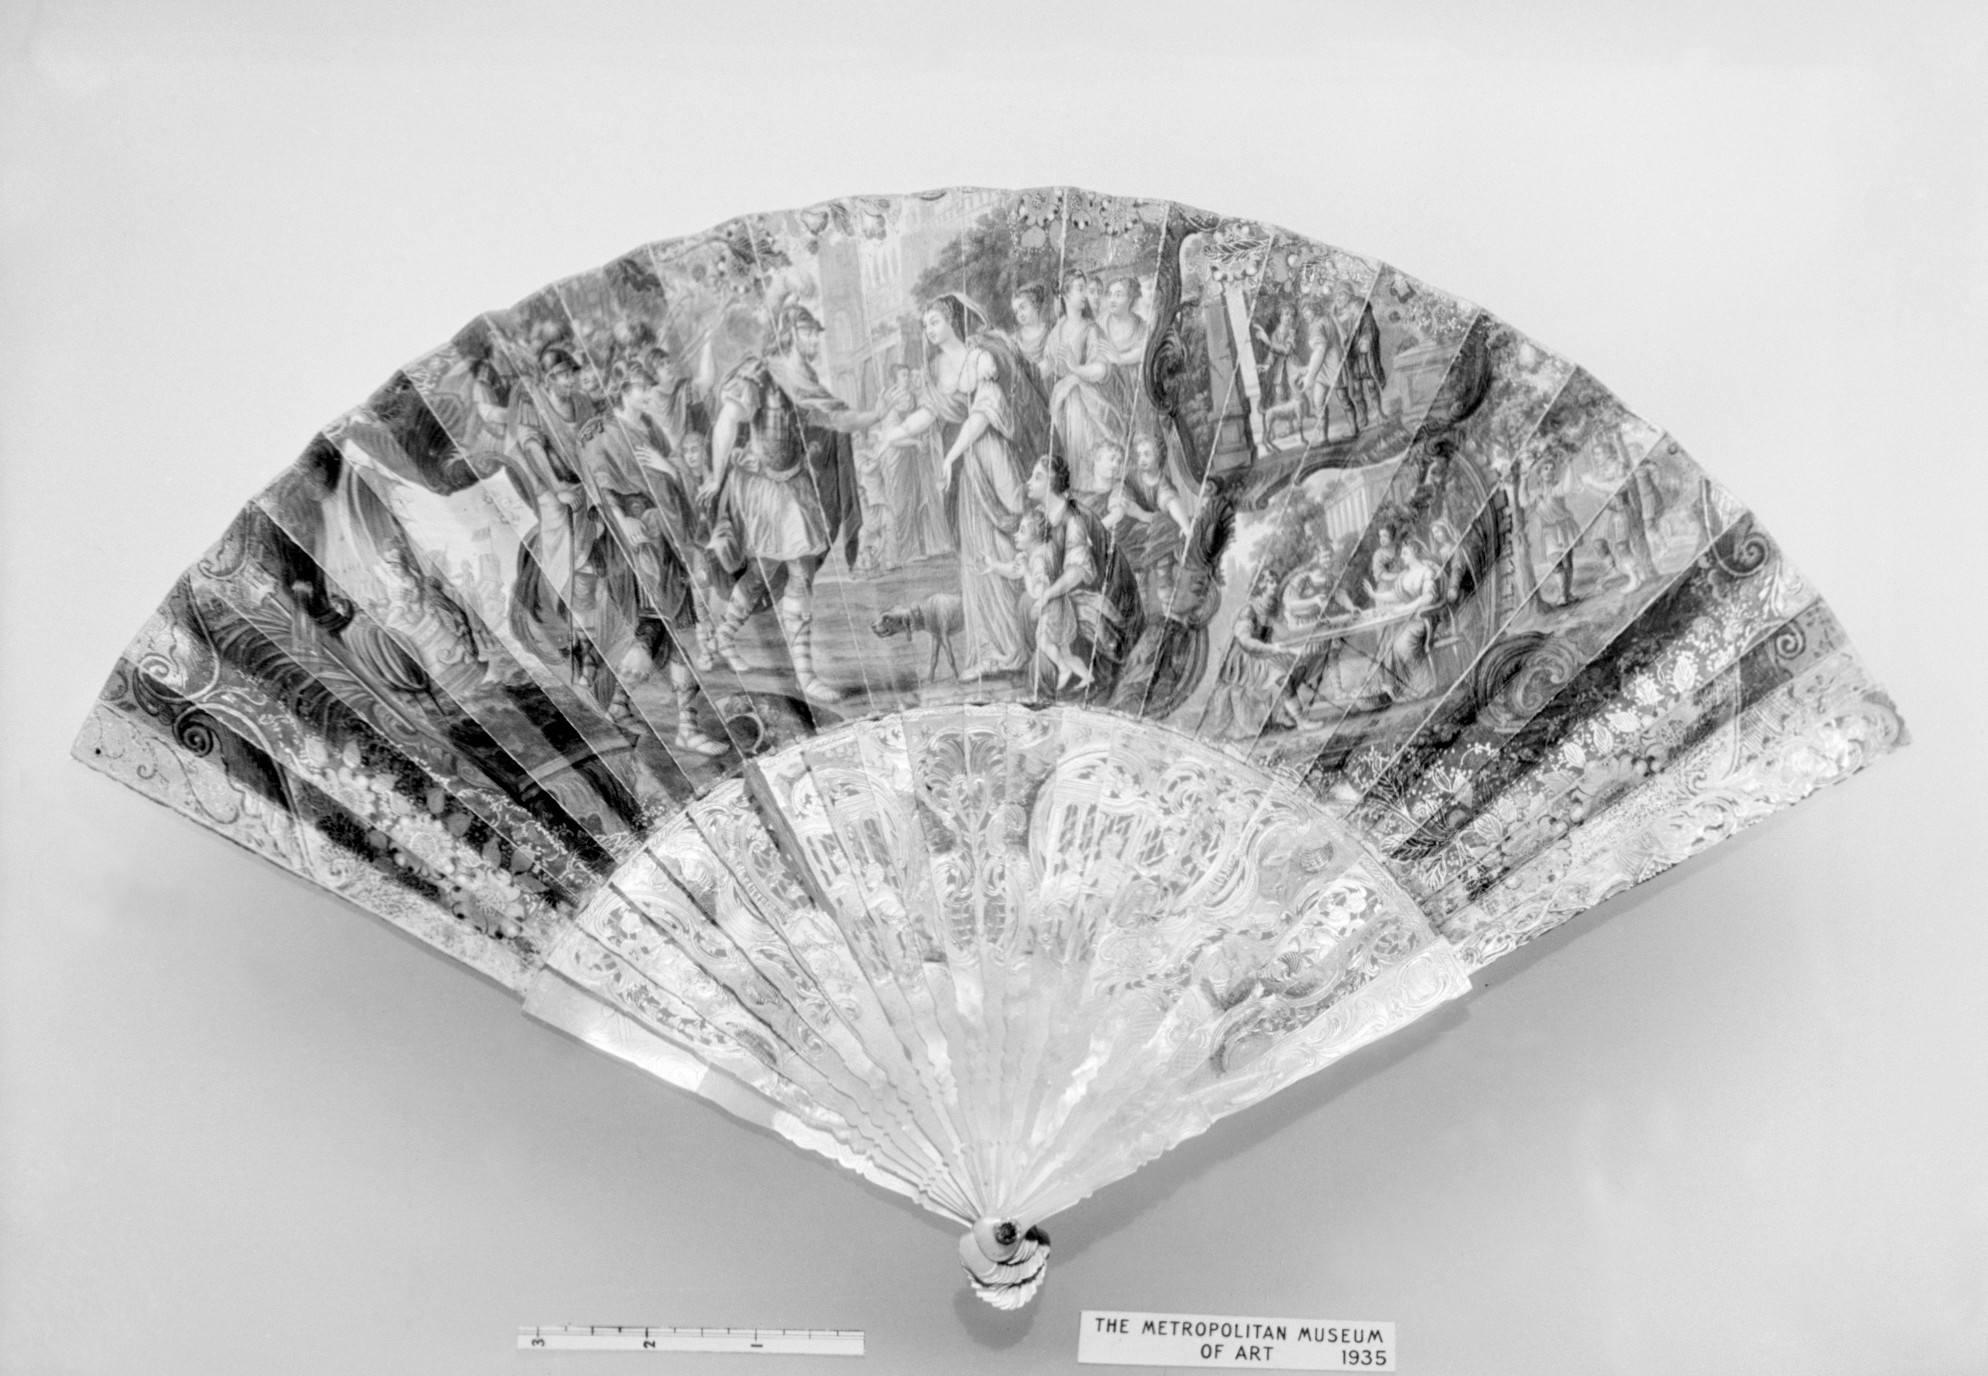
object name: fan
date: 1726-1750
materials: mother of pearl, paper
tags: children,men,women,dogs